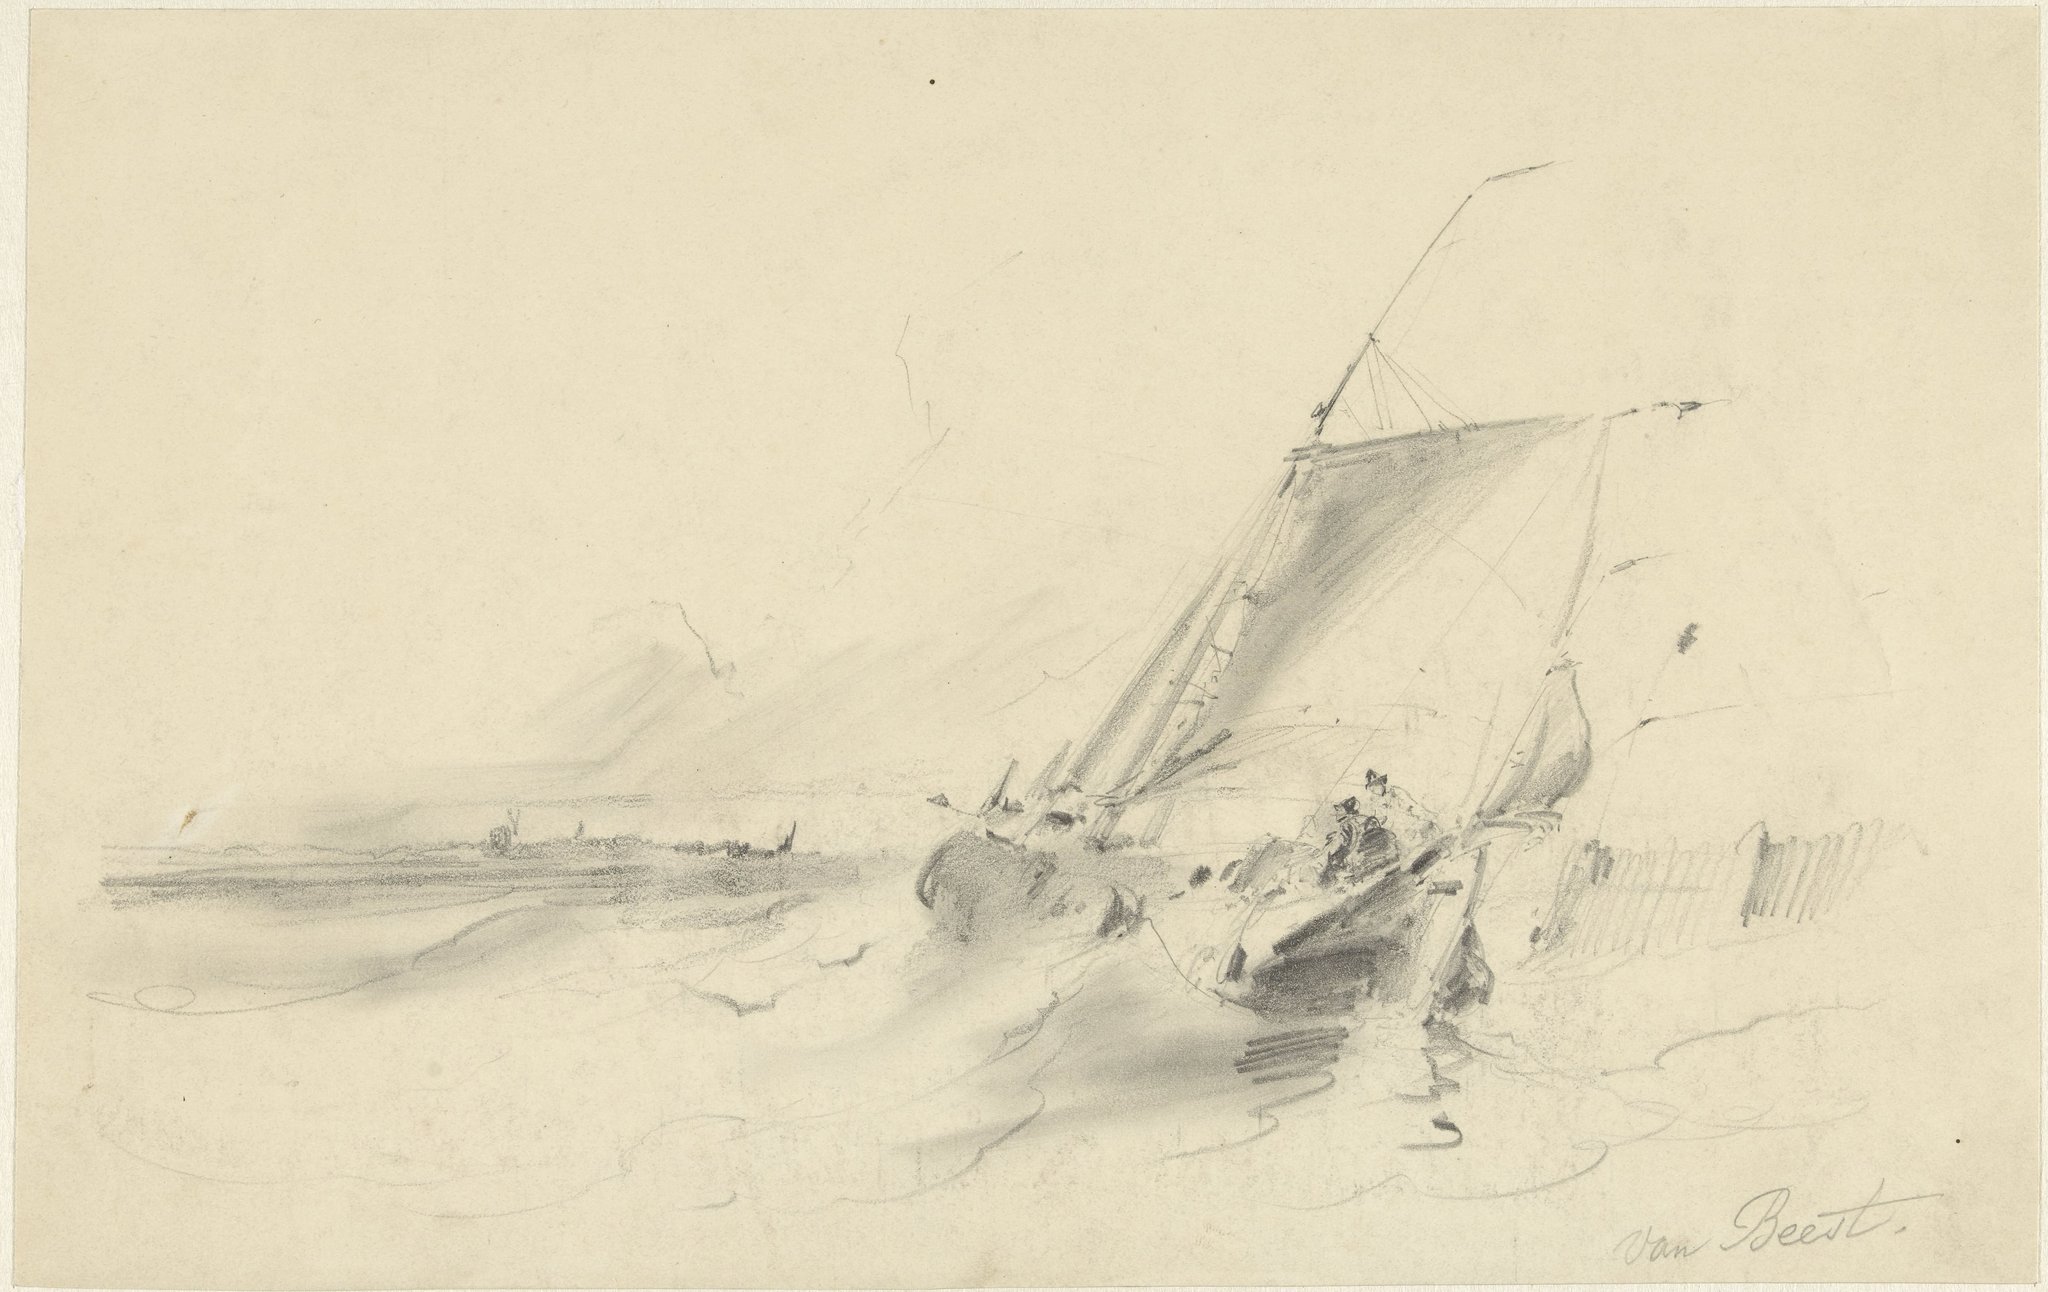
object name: drawing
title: Zeegezicht met schuit in woelig water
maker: albertus van beest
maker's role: draughtsman, print maker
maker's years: 1820-1860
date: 1830-1860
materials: paper, pencil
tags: sailing-ship, sailing-boat